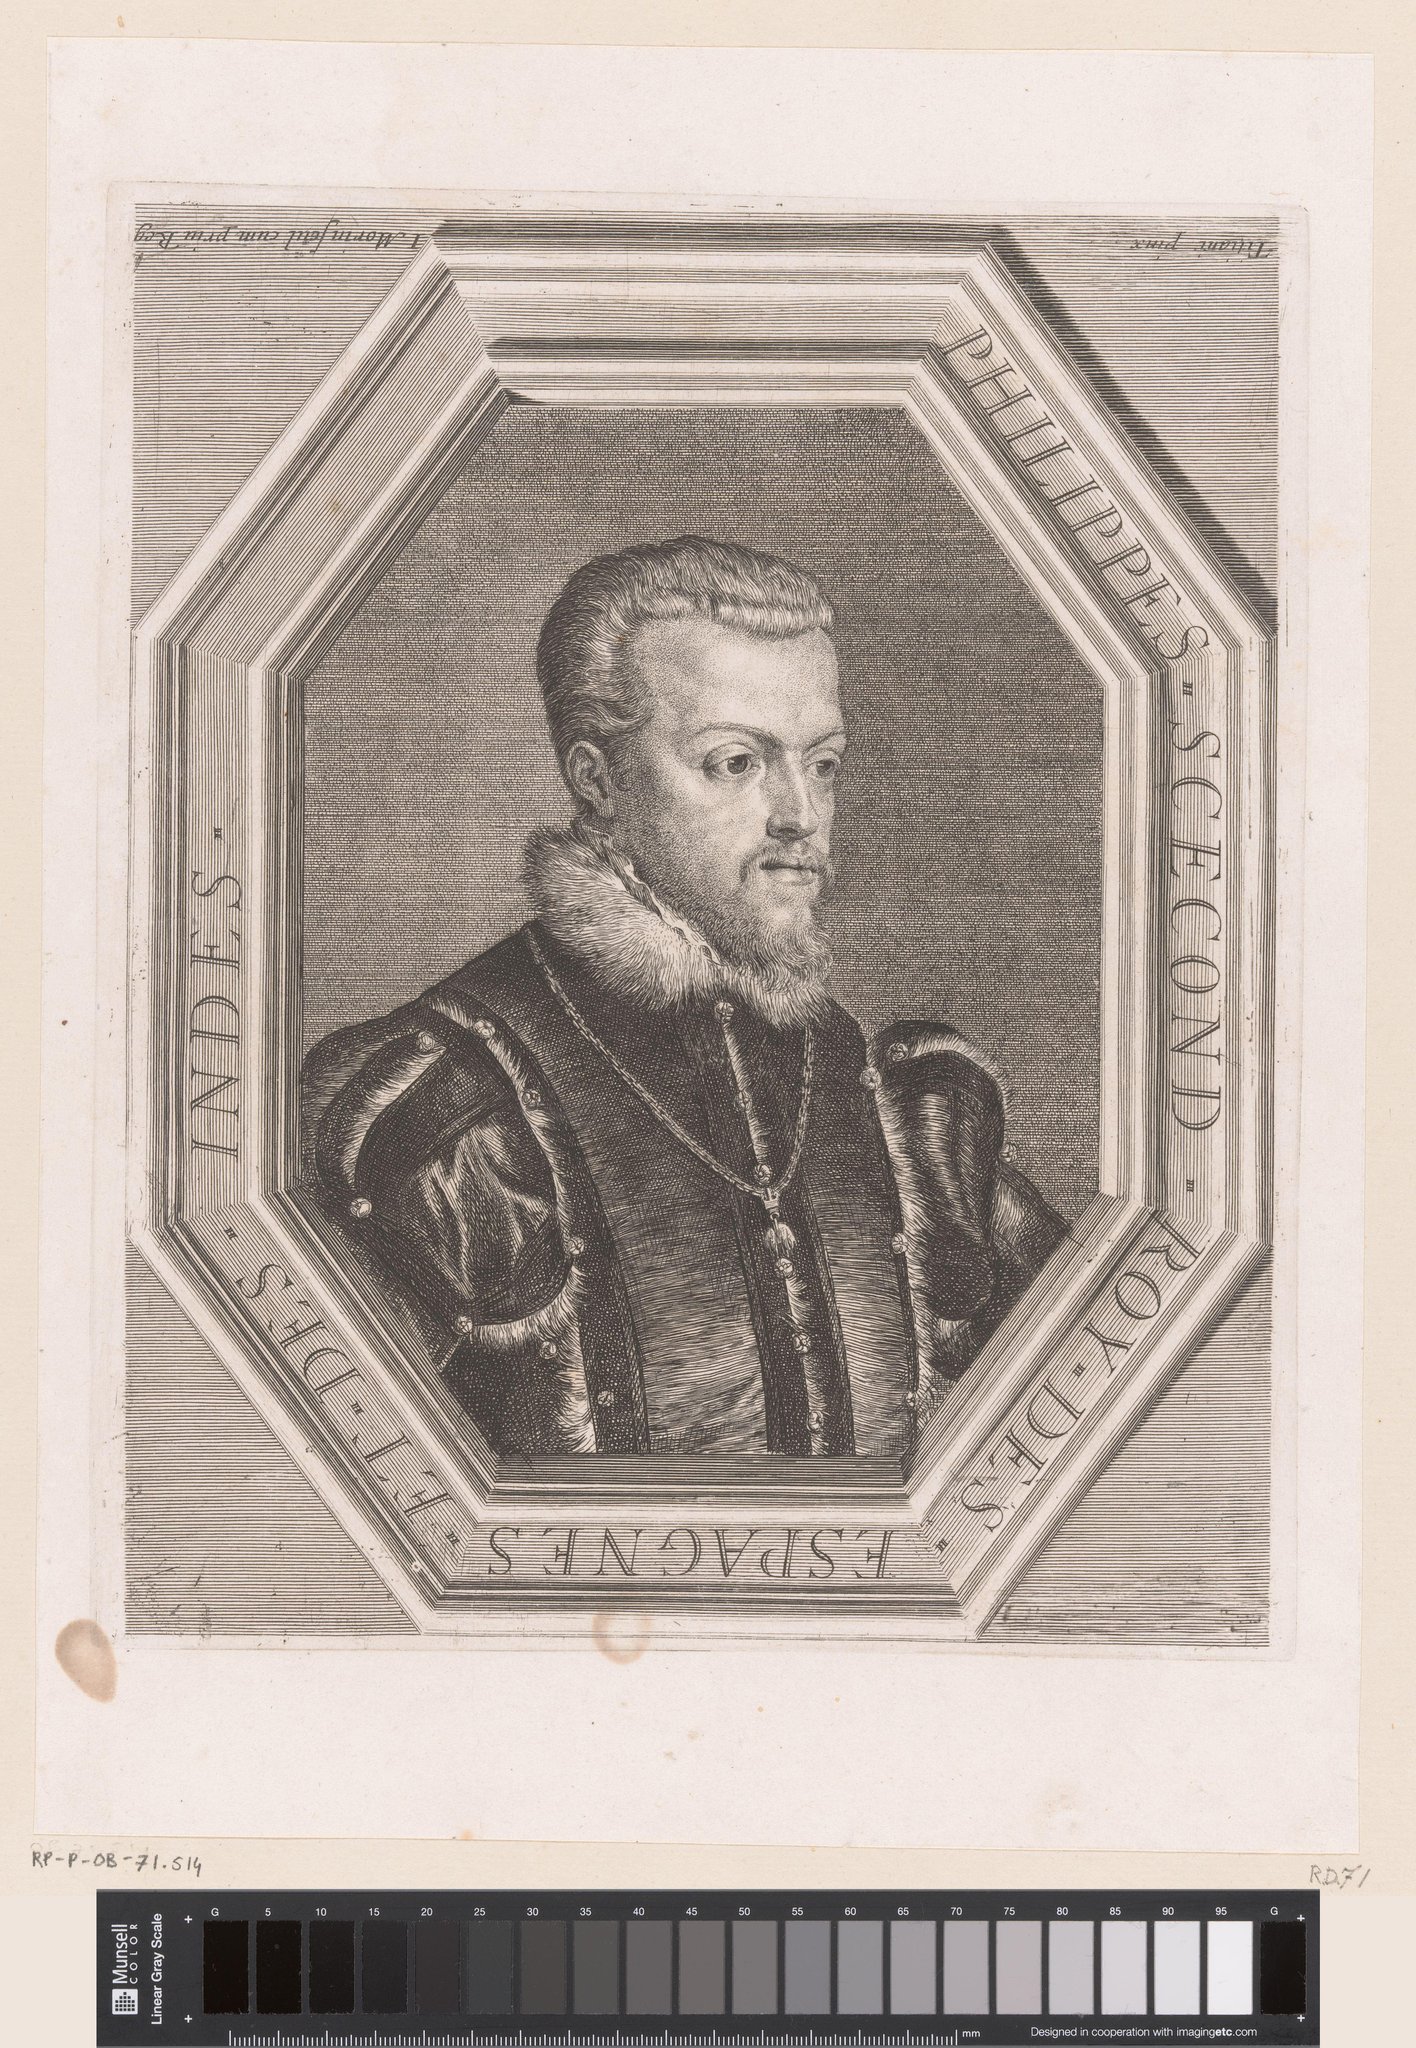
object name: print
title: Portret van Filips II, koning van Spanje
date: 1640-1650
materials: paper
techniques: engraving, etching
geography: france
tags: philip ii of spain, historical persons, king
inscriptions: collector's mark: Lugt 2228